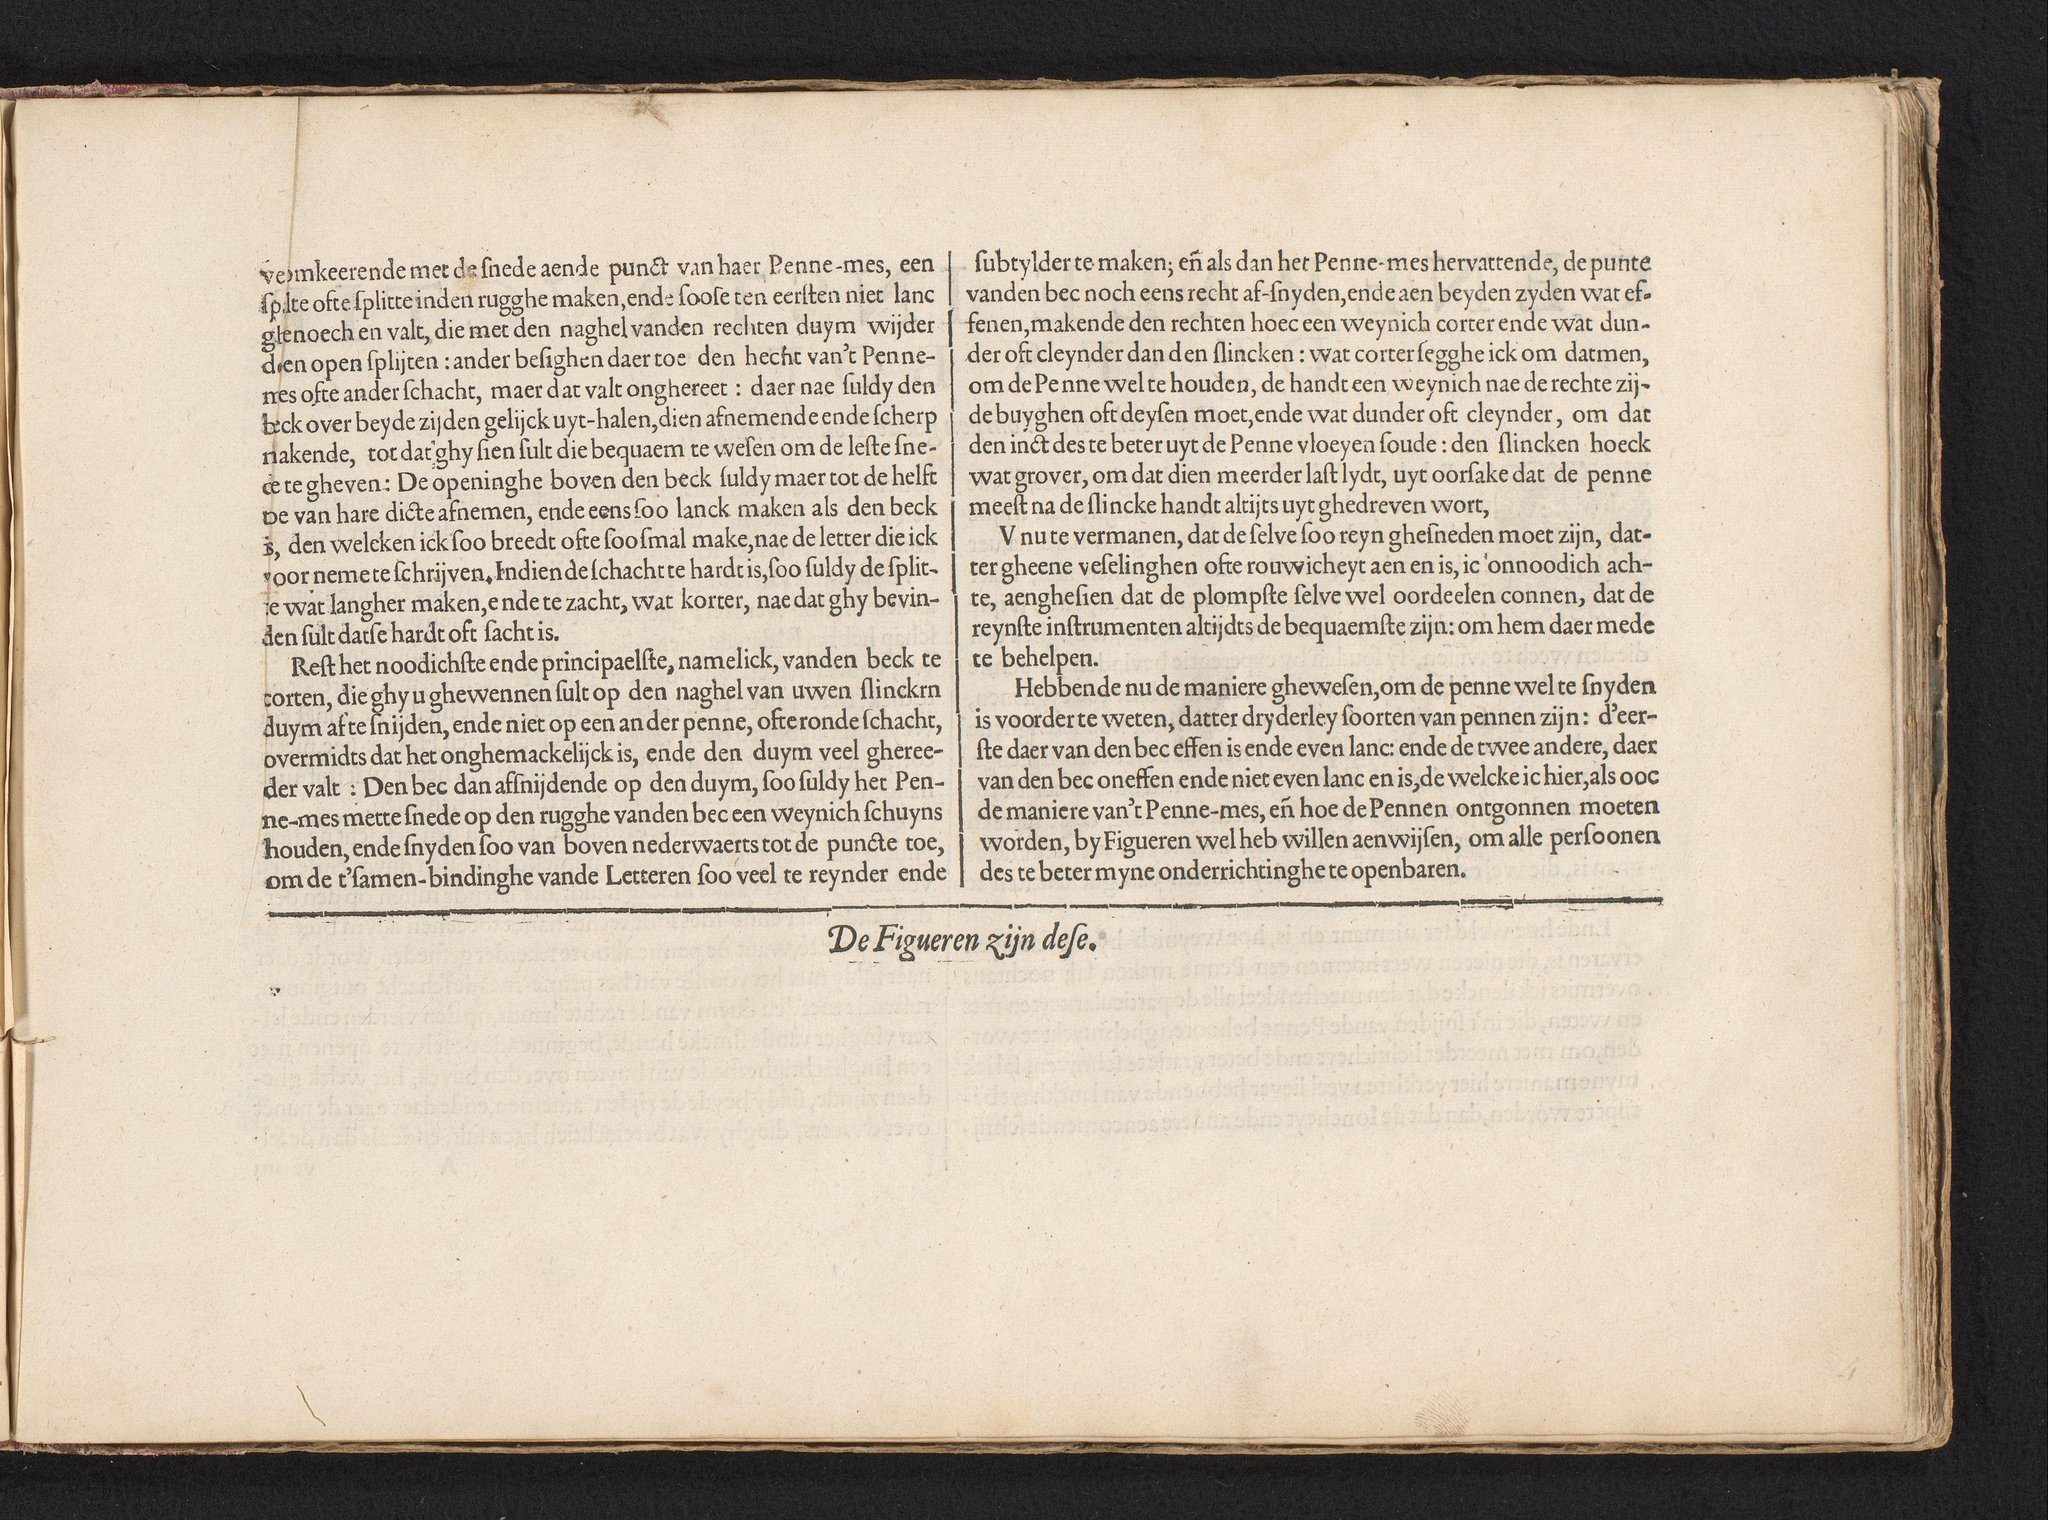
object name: text sheet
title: Generale instructie deses boecx. Grondich bericht om een goede penne te maken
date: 1608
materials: paper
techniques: letterpress printing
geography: rotterdam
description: Folio A1v met een instructie hoe je een goede rietpen maakt, pagina 2 van 2. Het tekstblad maakt deel uit van een album.